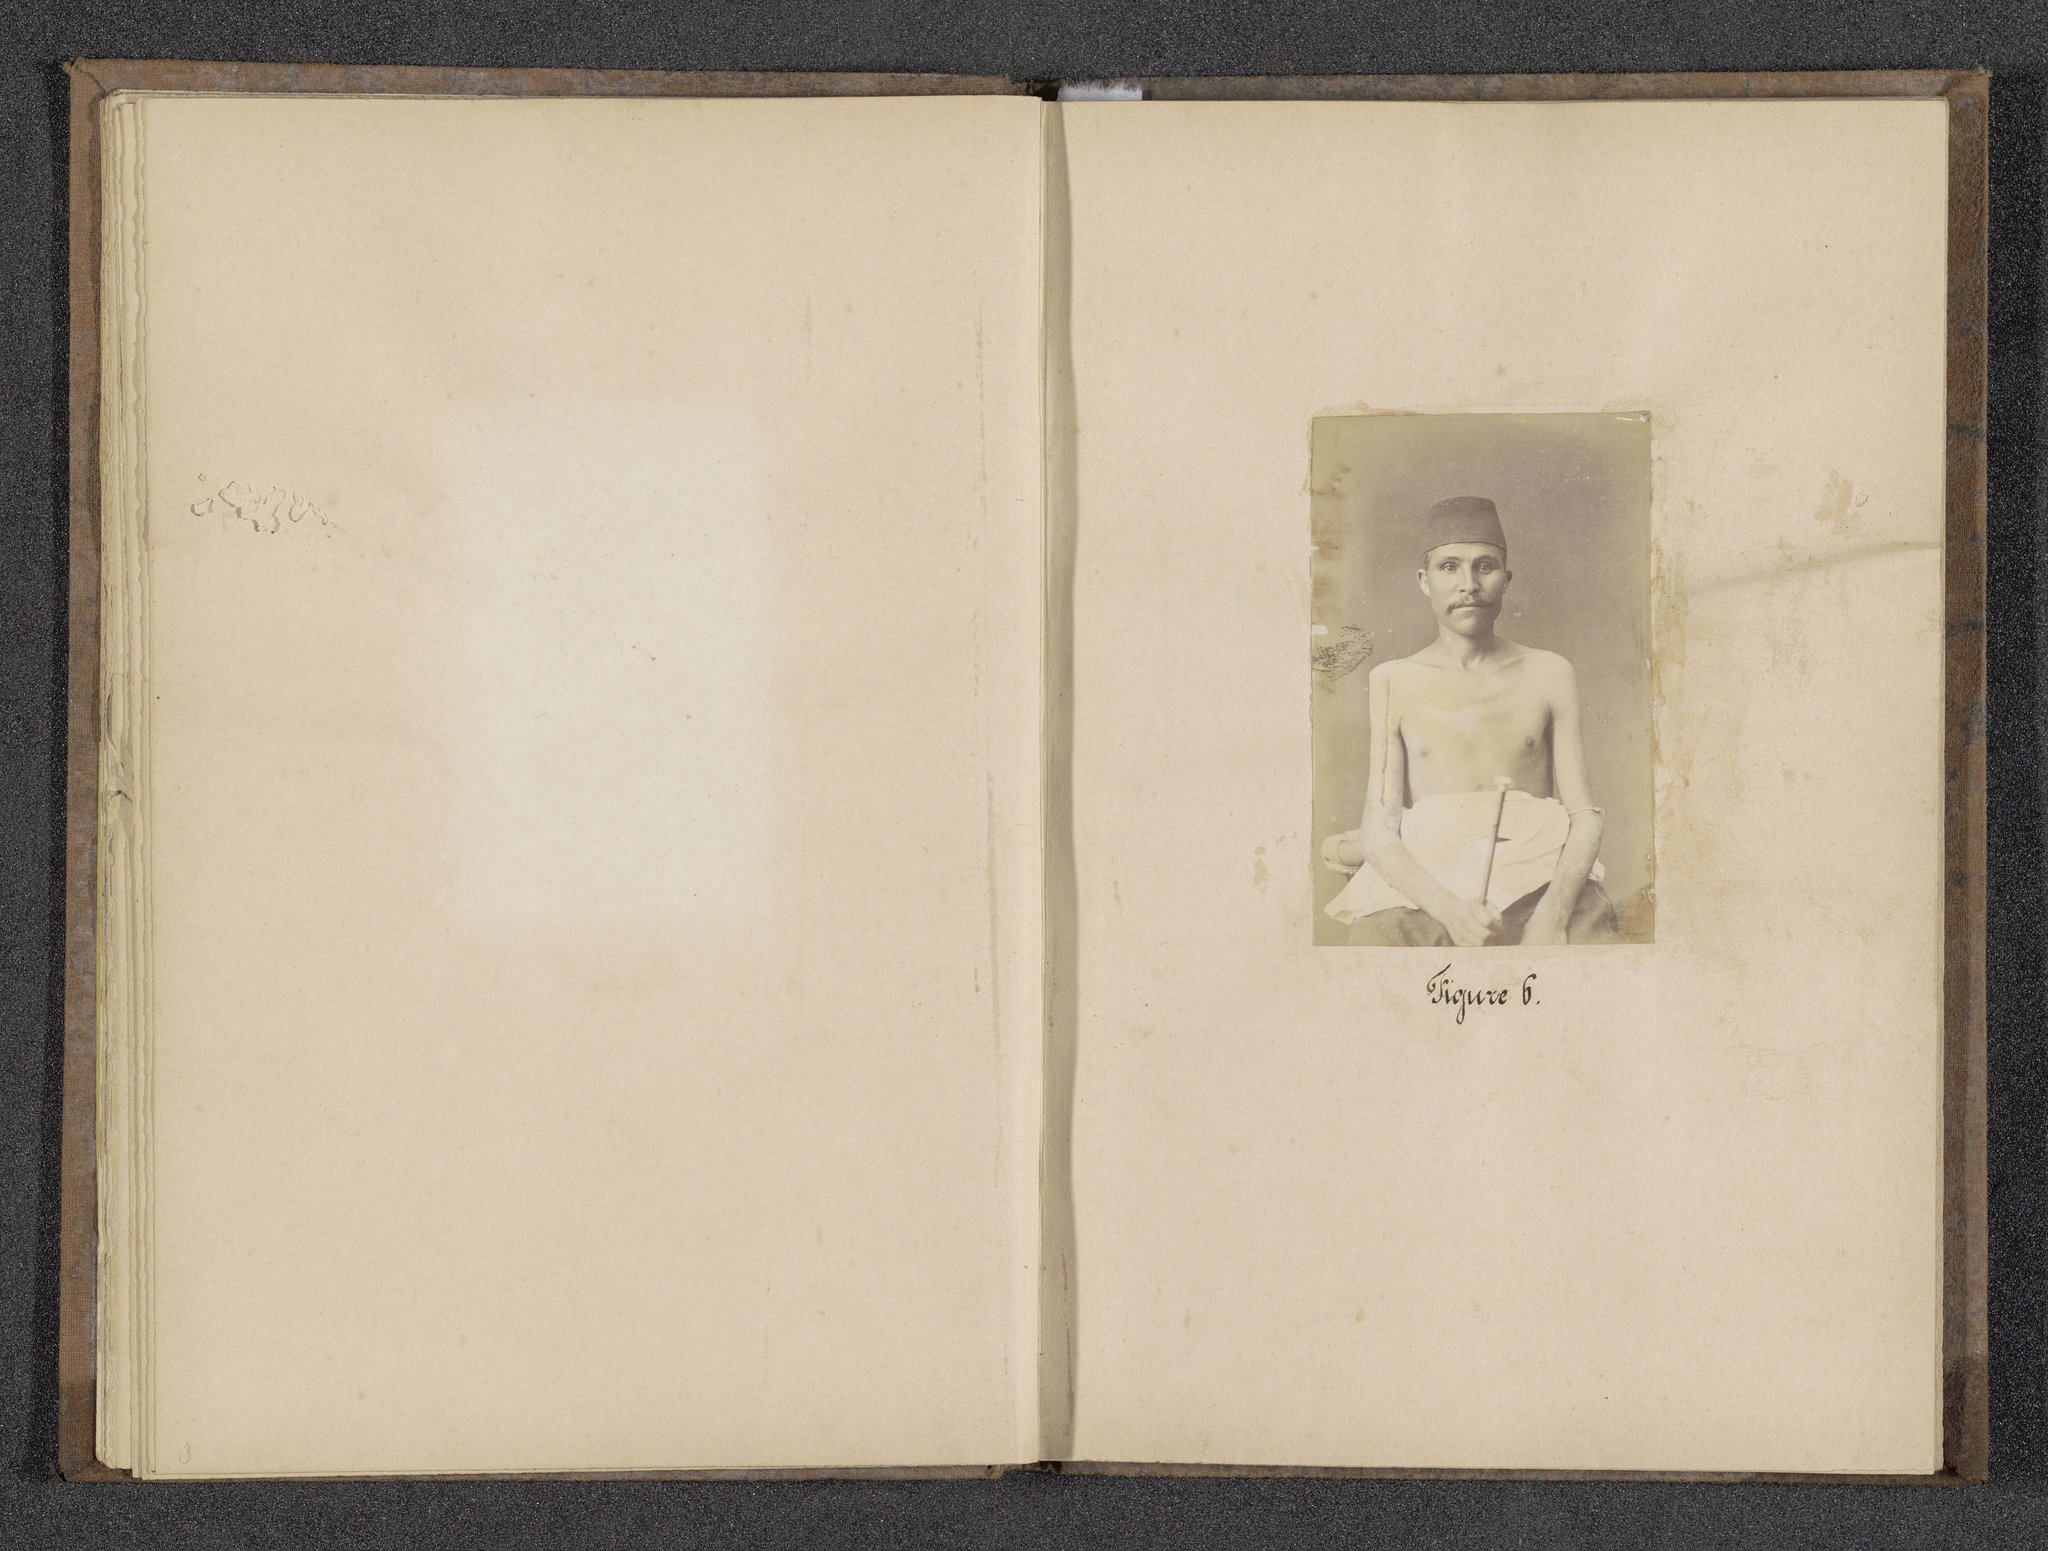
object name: photograph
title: Portret van Emewuj Omer, een patiënt met een deel van zijn opperarmbeen geamputeerd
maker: Anonymous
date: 1878-1880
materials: photographic support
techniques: albumen print, hand coloring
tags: arms, patient, sick person, amputation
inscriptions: number: ‘Figure 6.’